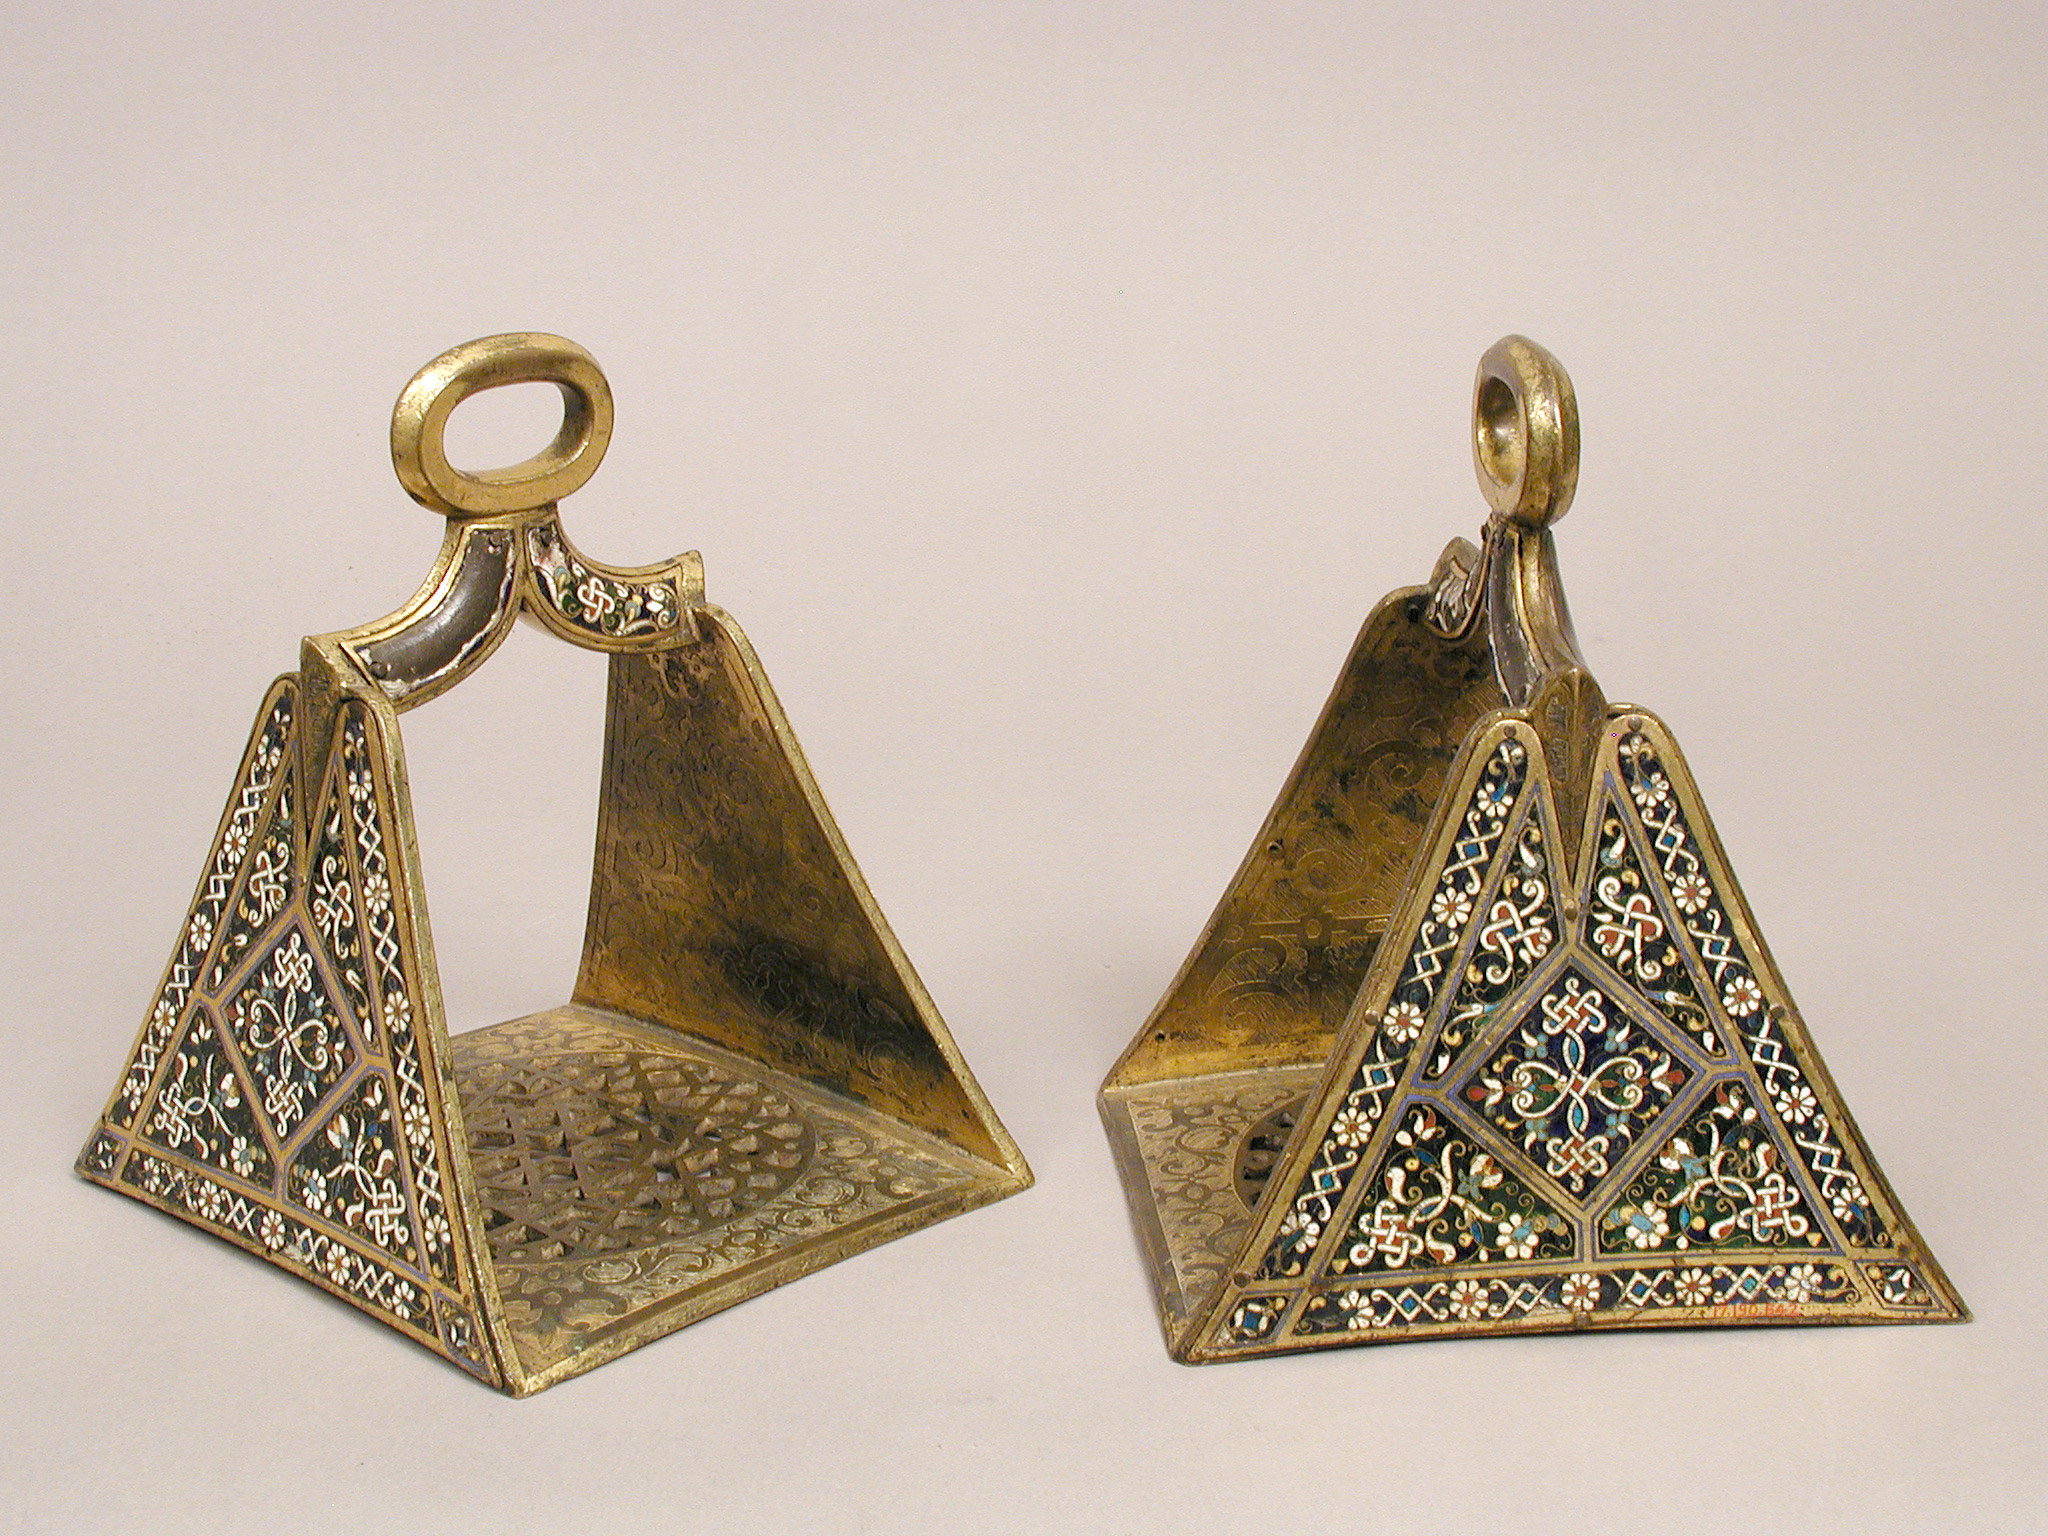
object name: stirrup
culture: spanish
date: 1492-1530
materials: gilt copper, enamel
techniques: enamel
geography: spain